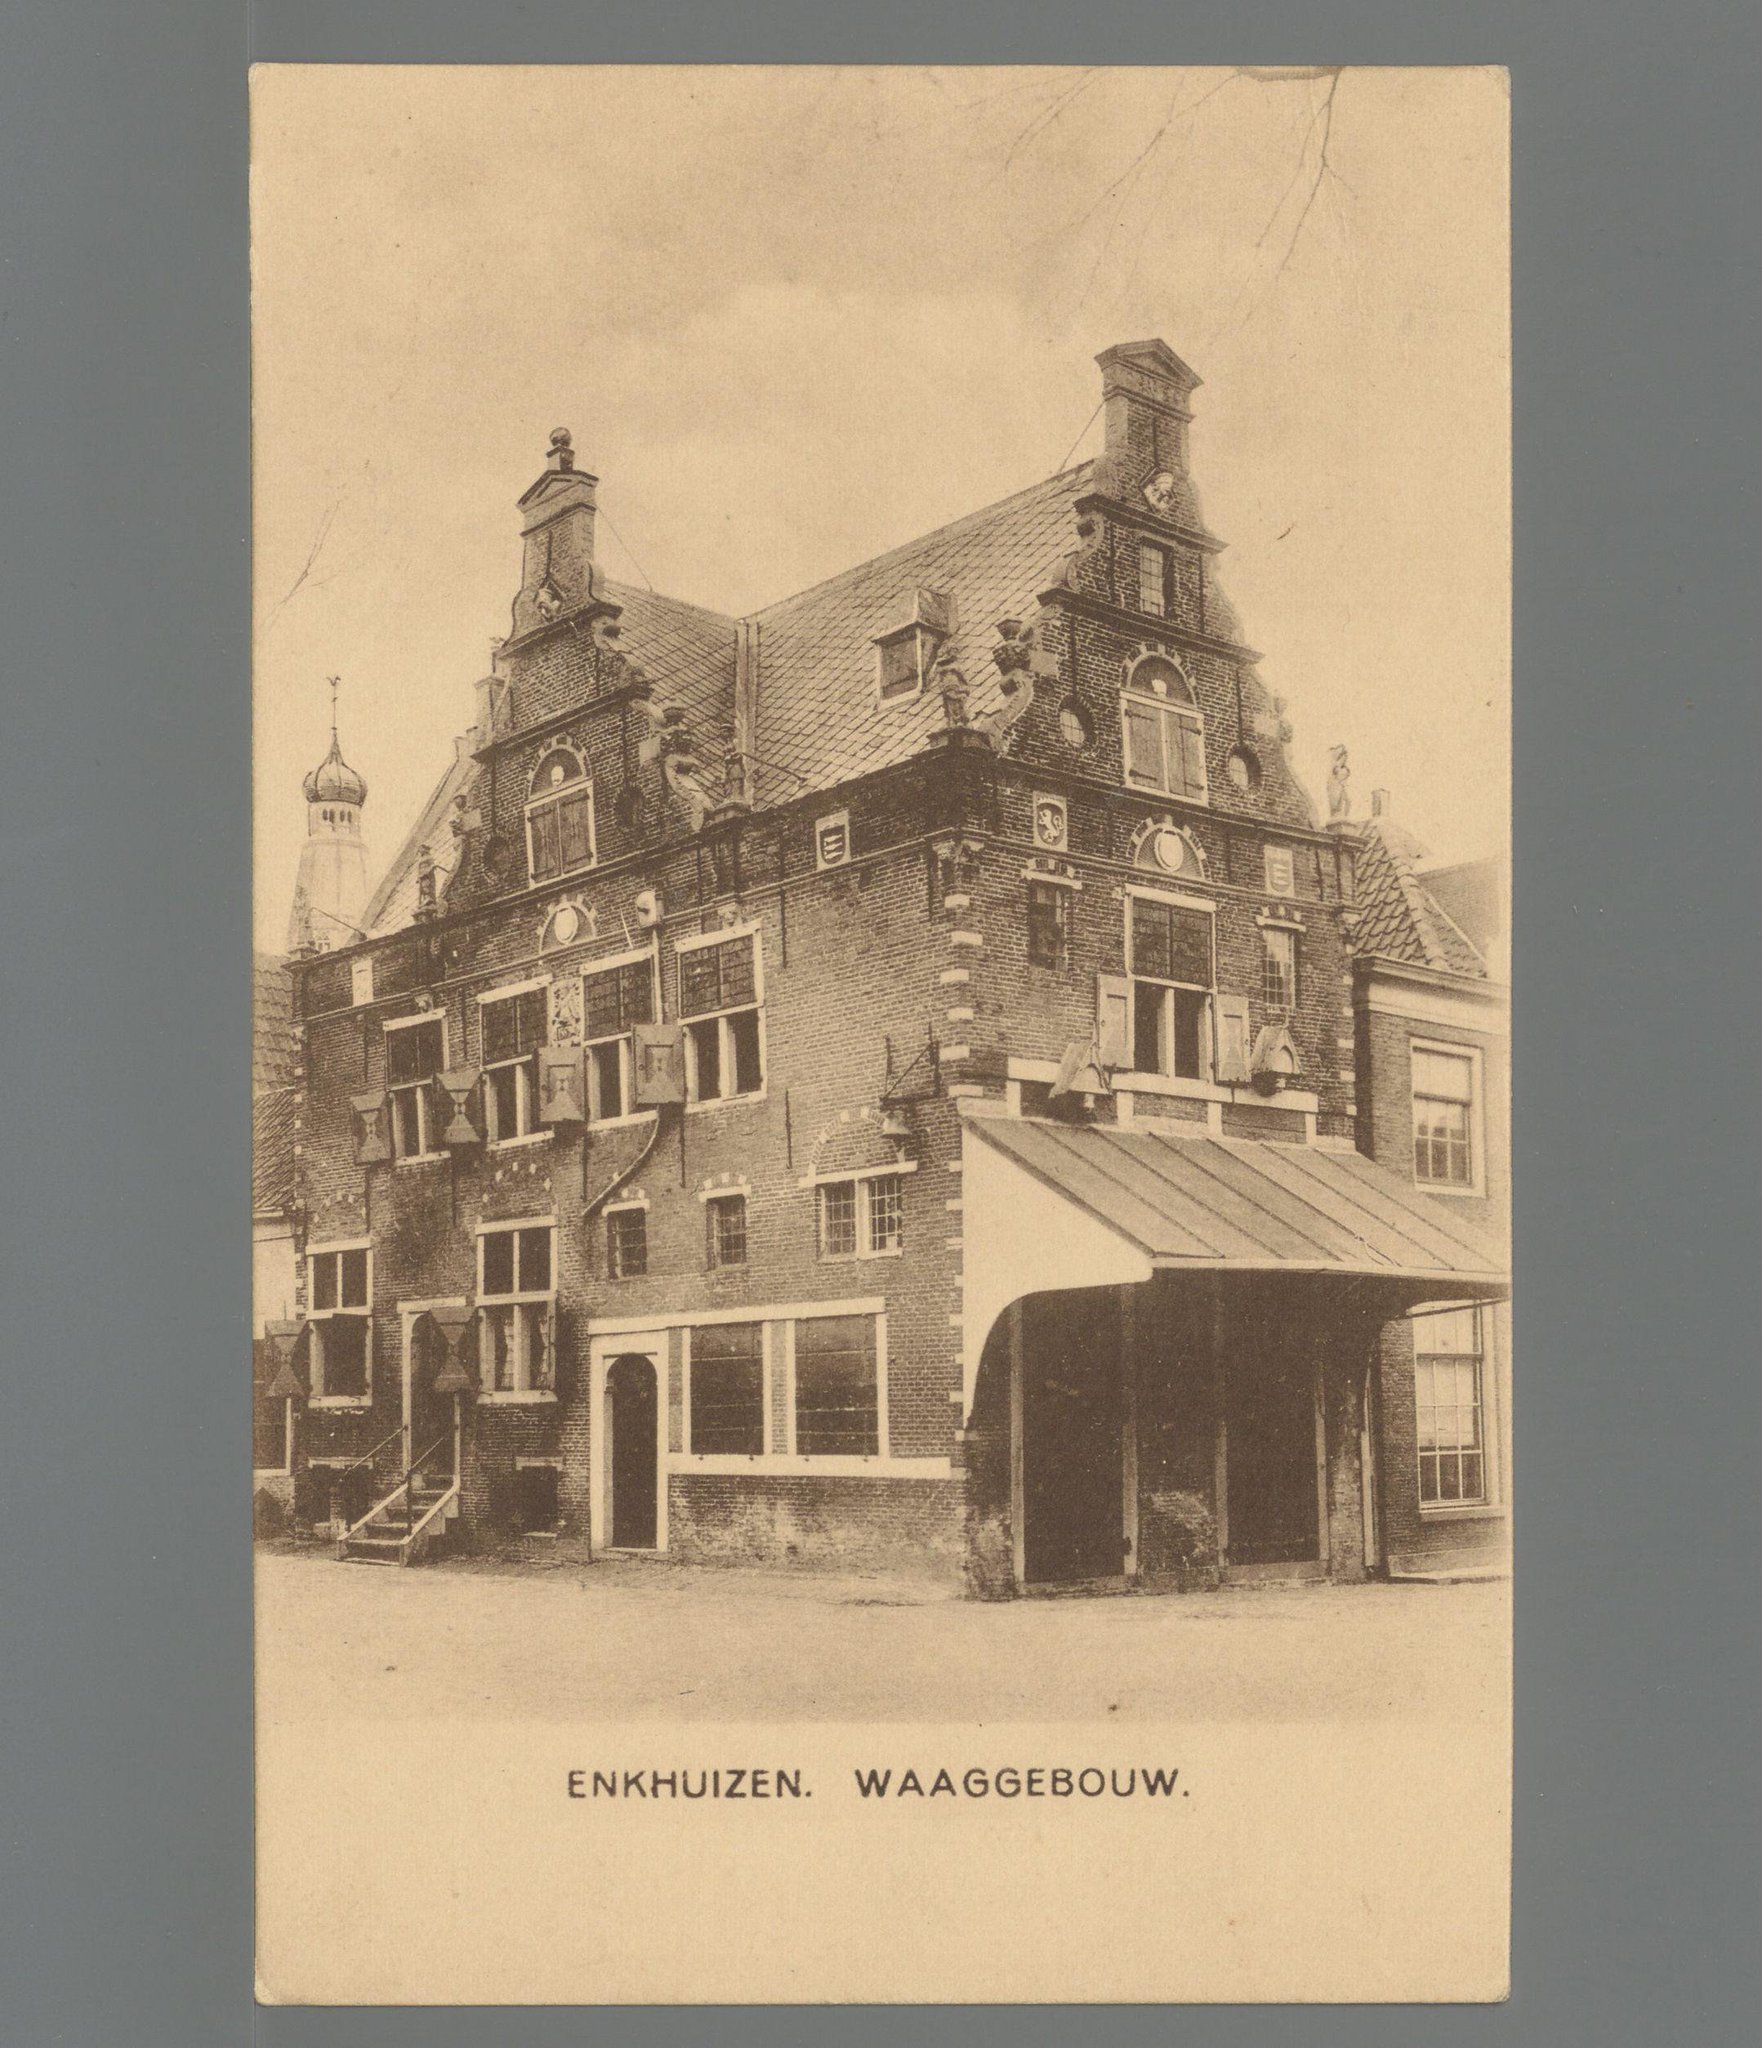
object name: ansichtkaart, prentbriefkaart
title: Enkhuizen. Waaggebouw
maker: Anonymous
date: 1905-1924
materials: cardboard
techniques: photograph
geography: enkhuizen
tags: weigh-house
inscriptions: postage stamp